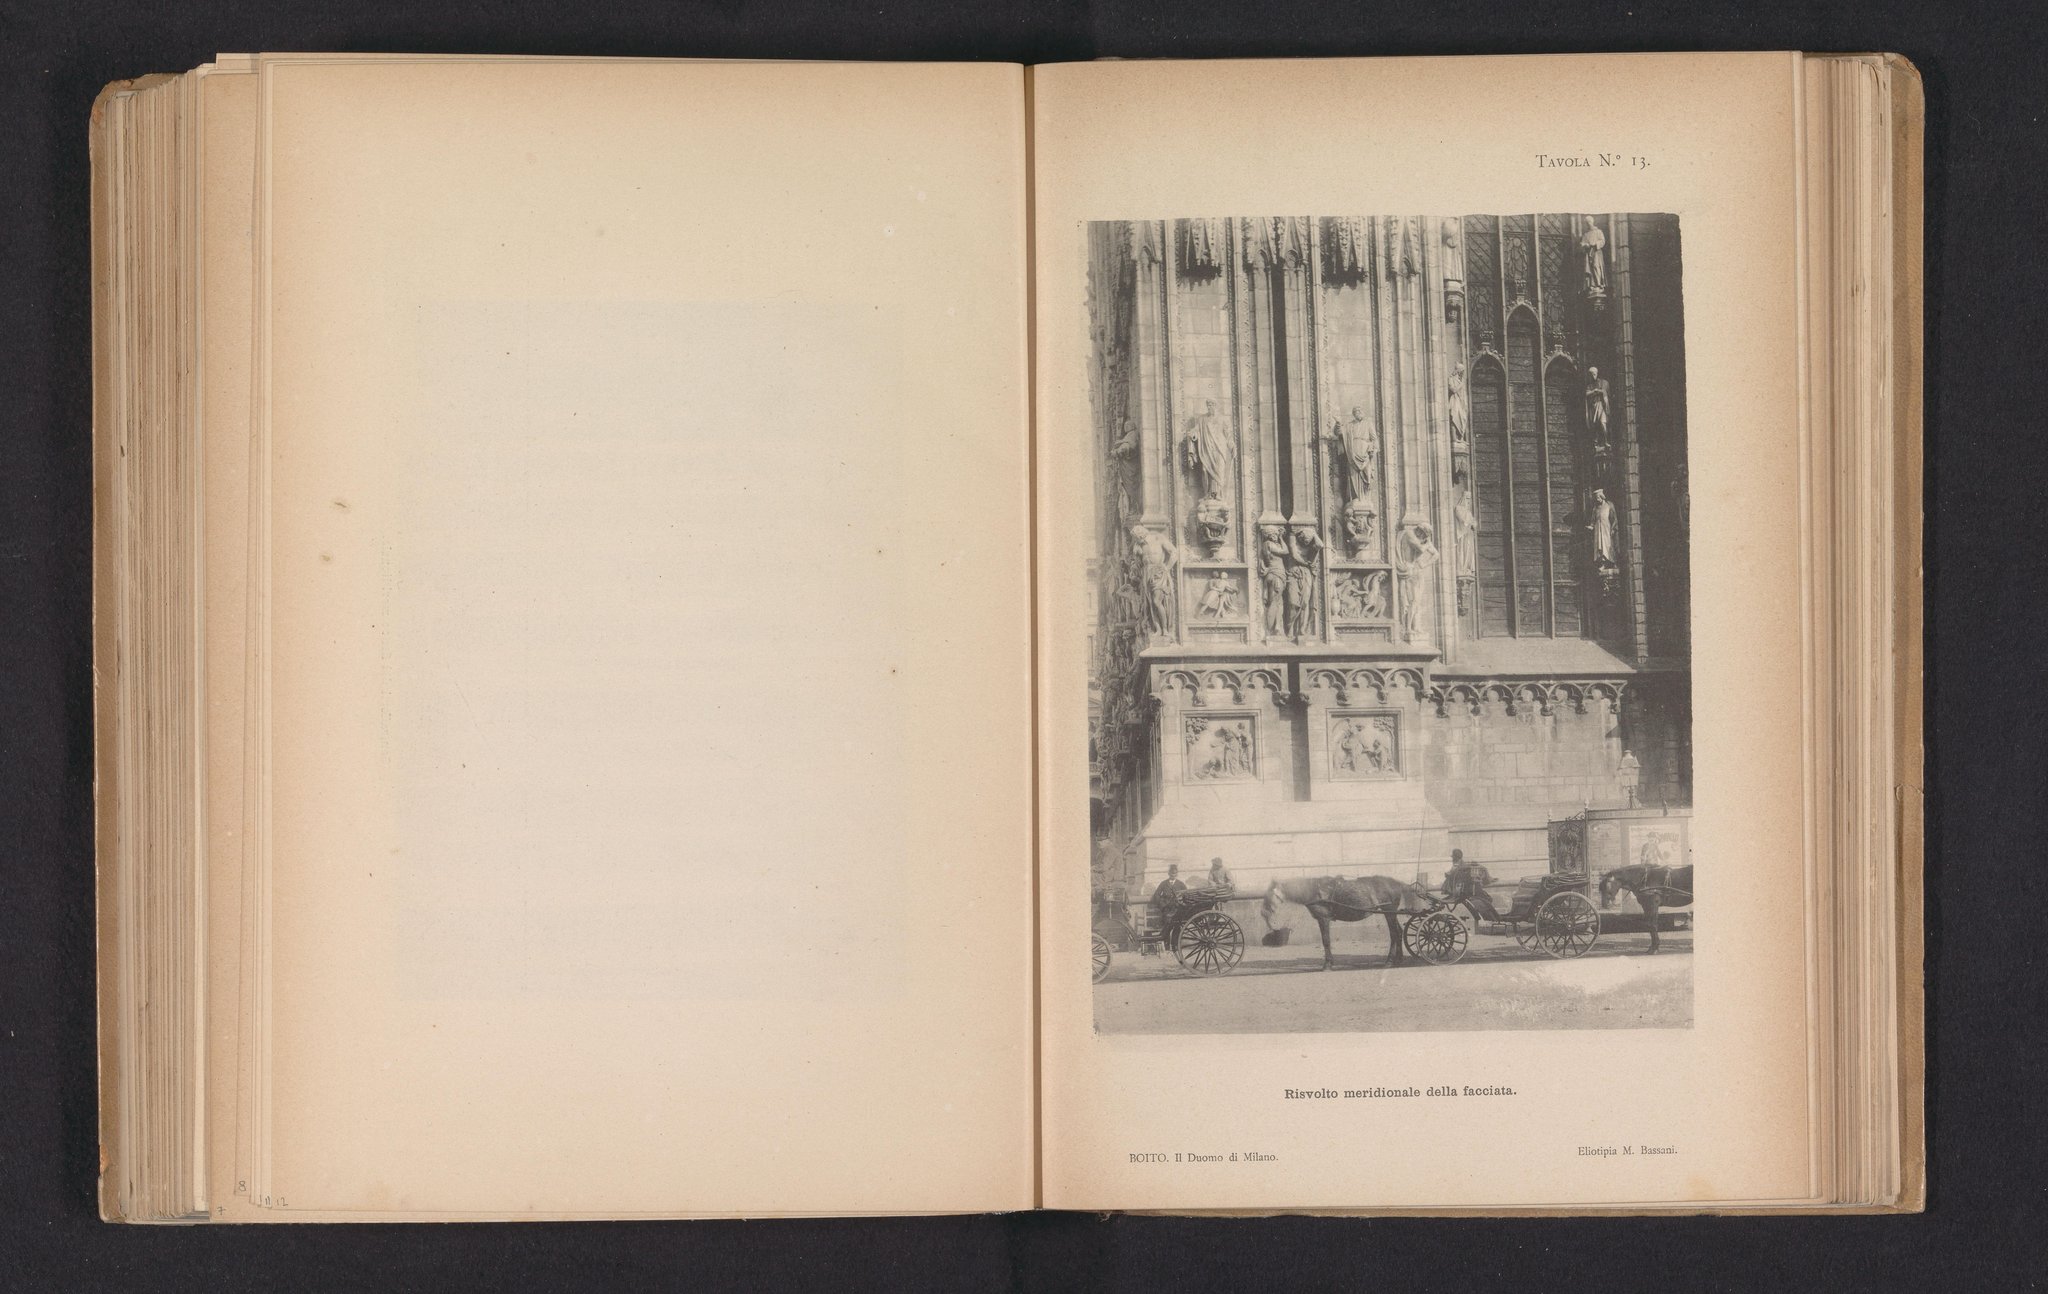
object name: photomechanical print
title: Risvolto meridionale della facciata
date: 1879-1889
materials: paper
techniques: photograph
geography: milan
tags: four-wheeled vehicle drawn by one animal, church (exterior), piece of sculpture, reproduction of a piece of sculpture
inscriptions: number: ‘Tavola No. 13.’